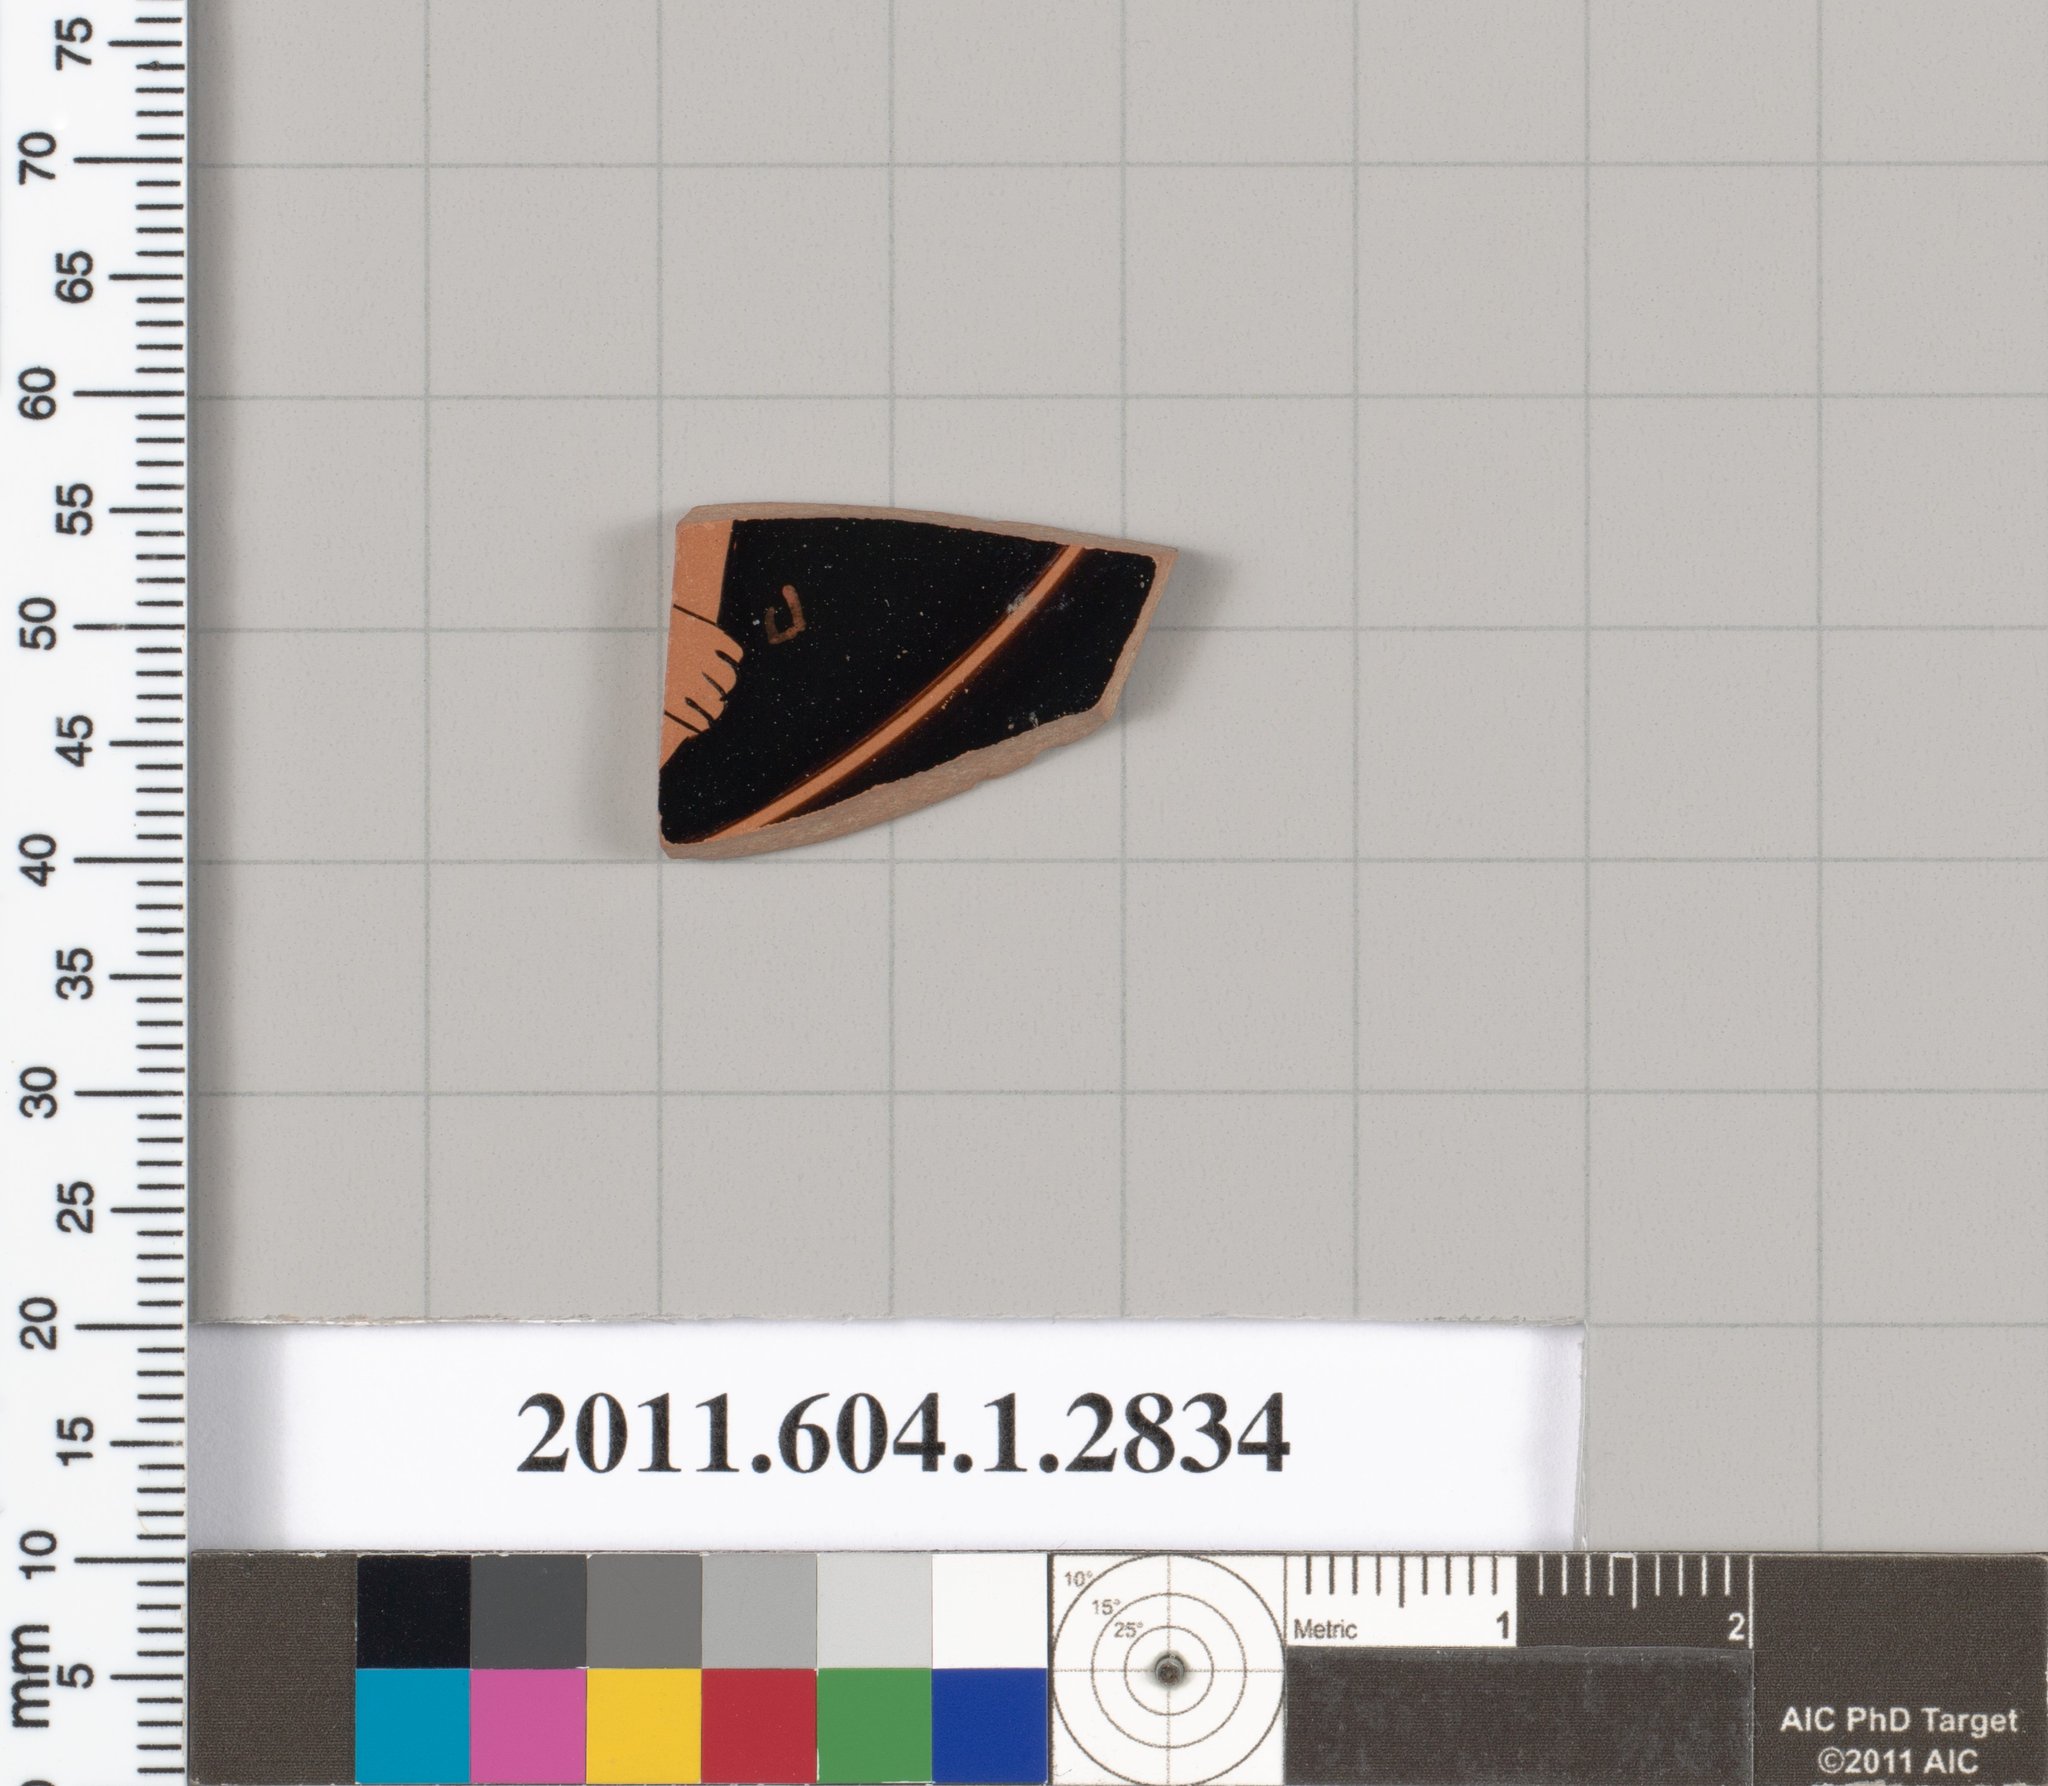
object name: kylix fragment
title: Terracotta fragment of a kylix (drinking cup)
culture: greek, attic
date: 520-500 BCE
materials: terracotta